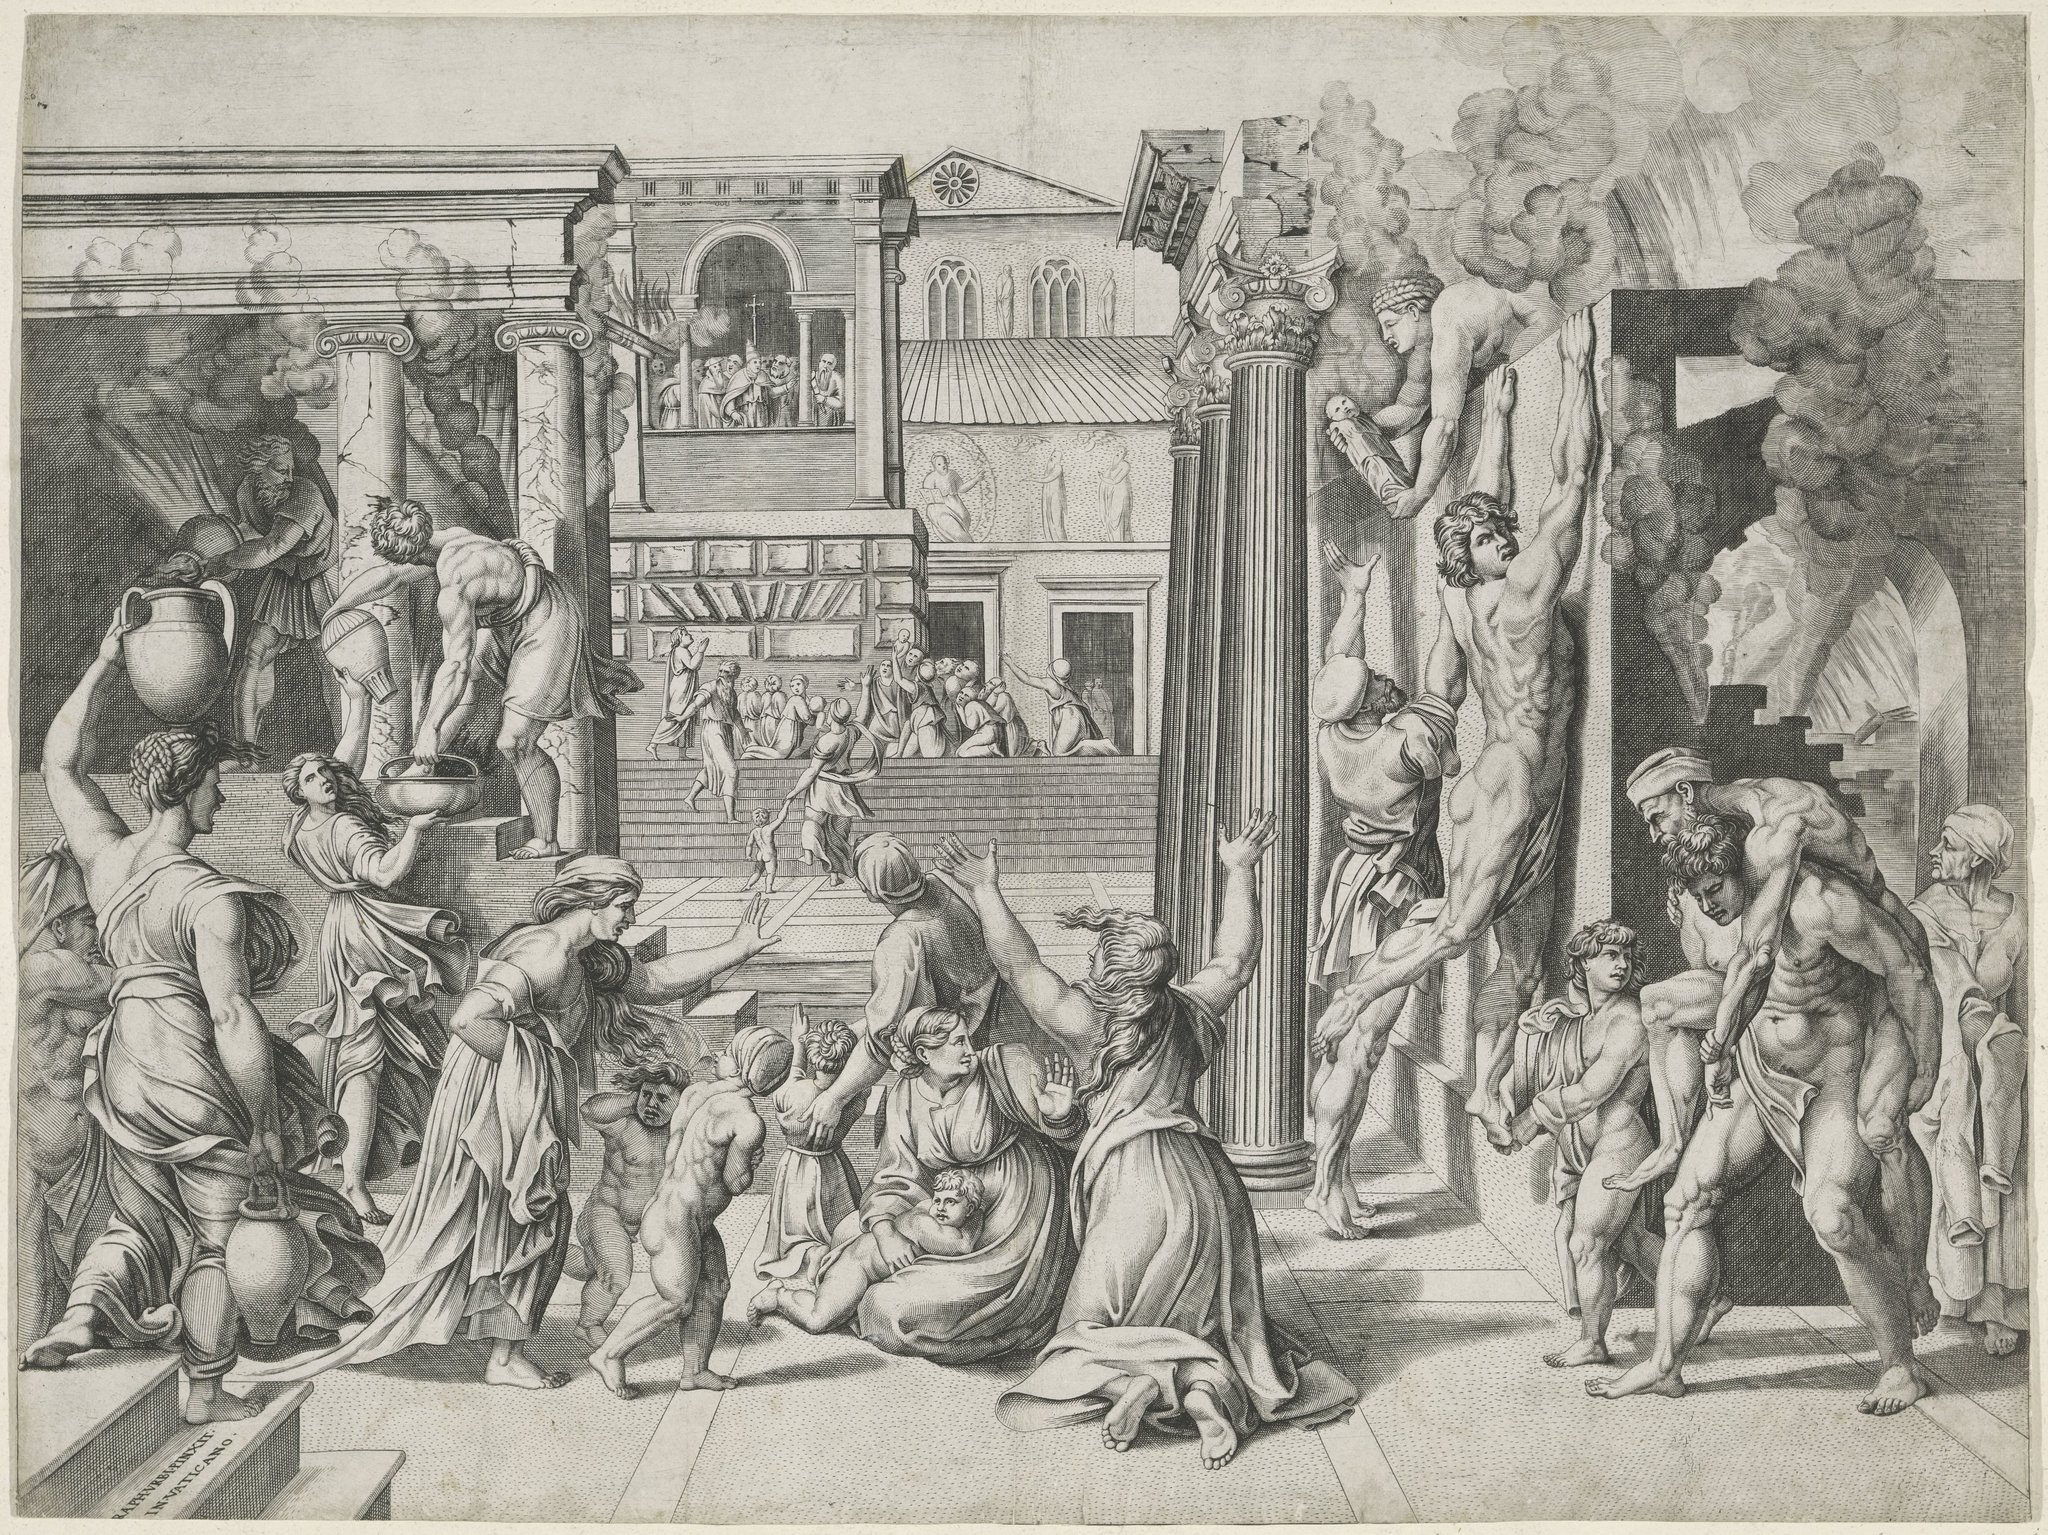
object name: print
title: Brand in de Borgo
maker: rafaël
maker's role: painter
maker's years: 1483-1520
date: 1514-1527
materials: paper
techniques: engraving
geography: vatican city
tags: rome, on fire, ablaze, pope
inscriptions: collector's mark: ‘7983’, collector's mark: ‘BILD’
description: Naar een fresco door Rafaël in de Stanza dell'Incendio di Borgo, Palazzi Pontifici, Vatican. Licht afzetsel van een andere prent op verso.